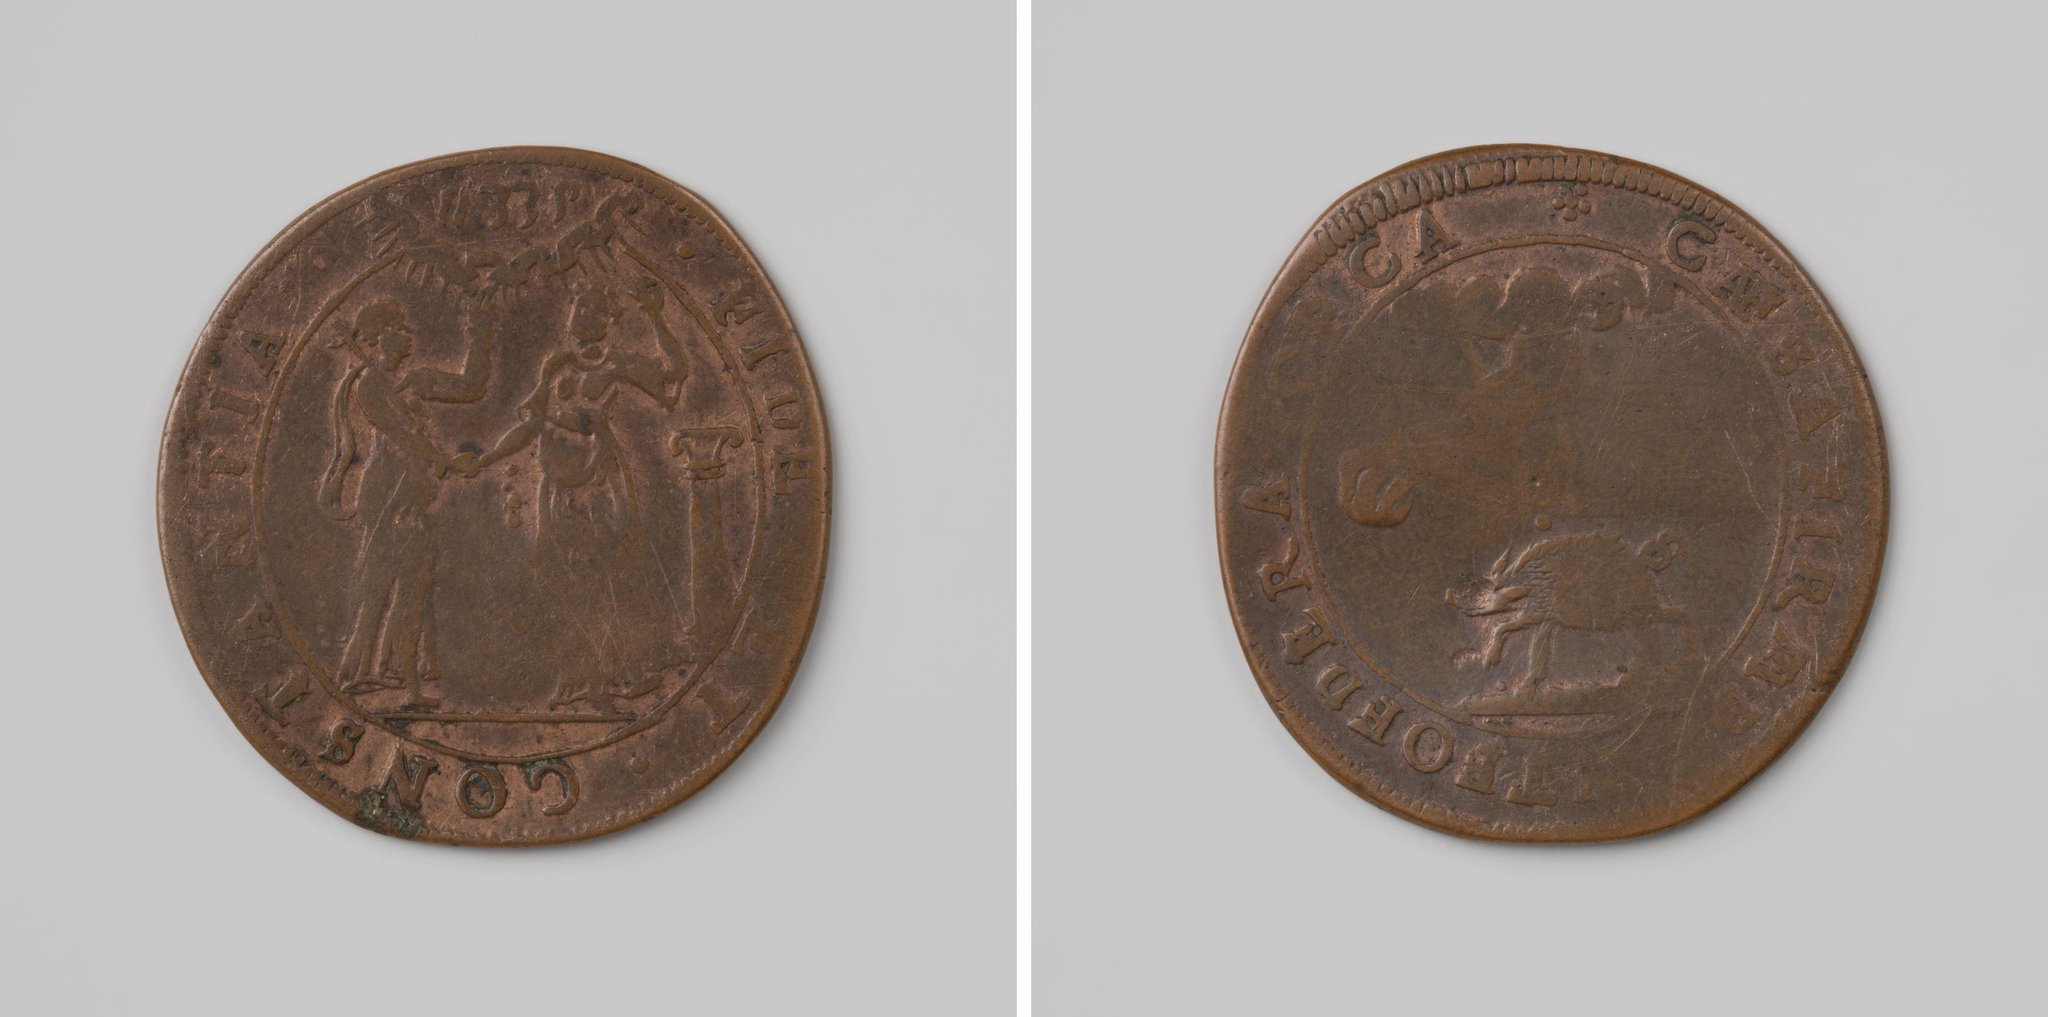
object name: jeton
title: Sluiting van het drievoudige verbond tussen Engeland, Frankrijk en de Republiek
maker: Anonymous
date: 1596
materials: copper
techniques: striking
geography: dordrecht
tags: netherlands, france, england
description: Koperen penning. Voorzijde: beschenen door hemellicht met daarin naam Jehova in Hebreeuws schrift geven Geloof met kruis en Standvastigheid, staande voor zuil, elkaar hand binnen omschrift. Keerzijde: zwijn; daarboven: arm uit wolken met kei in hand binnen omschrift.